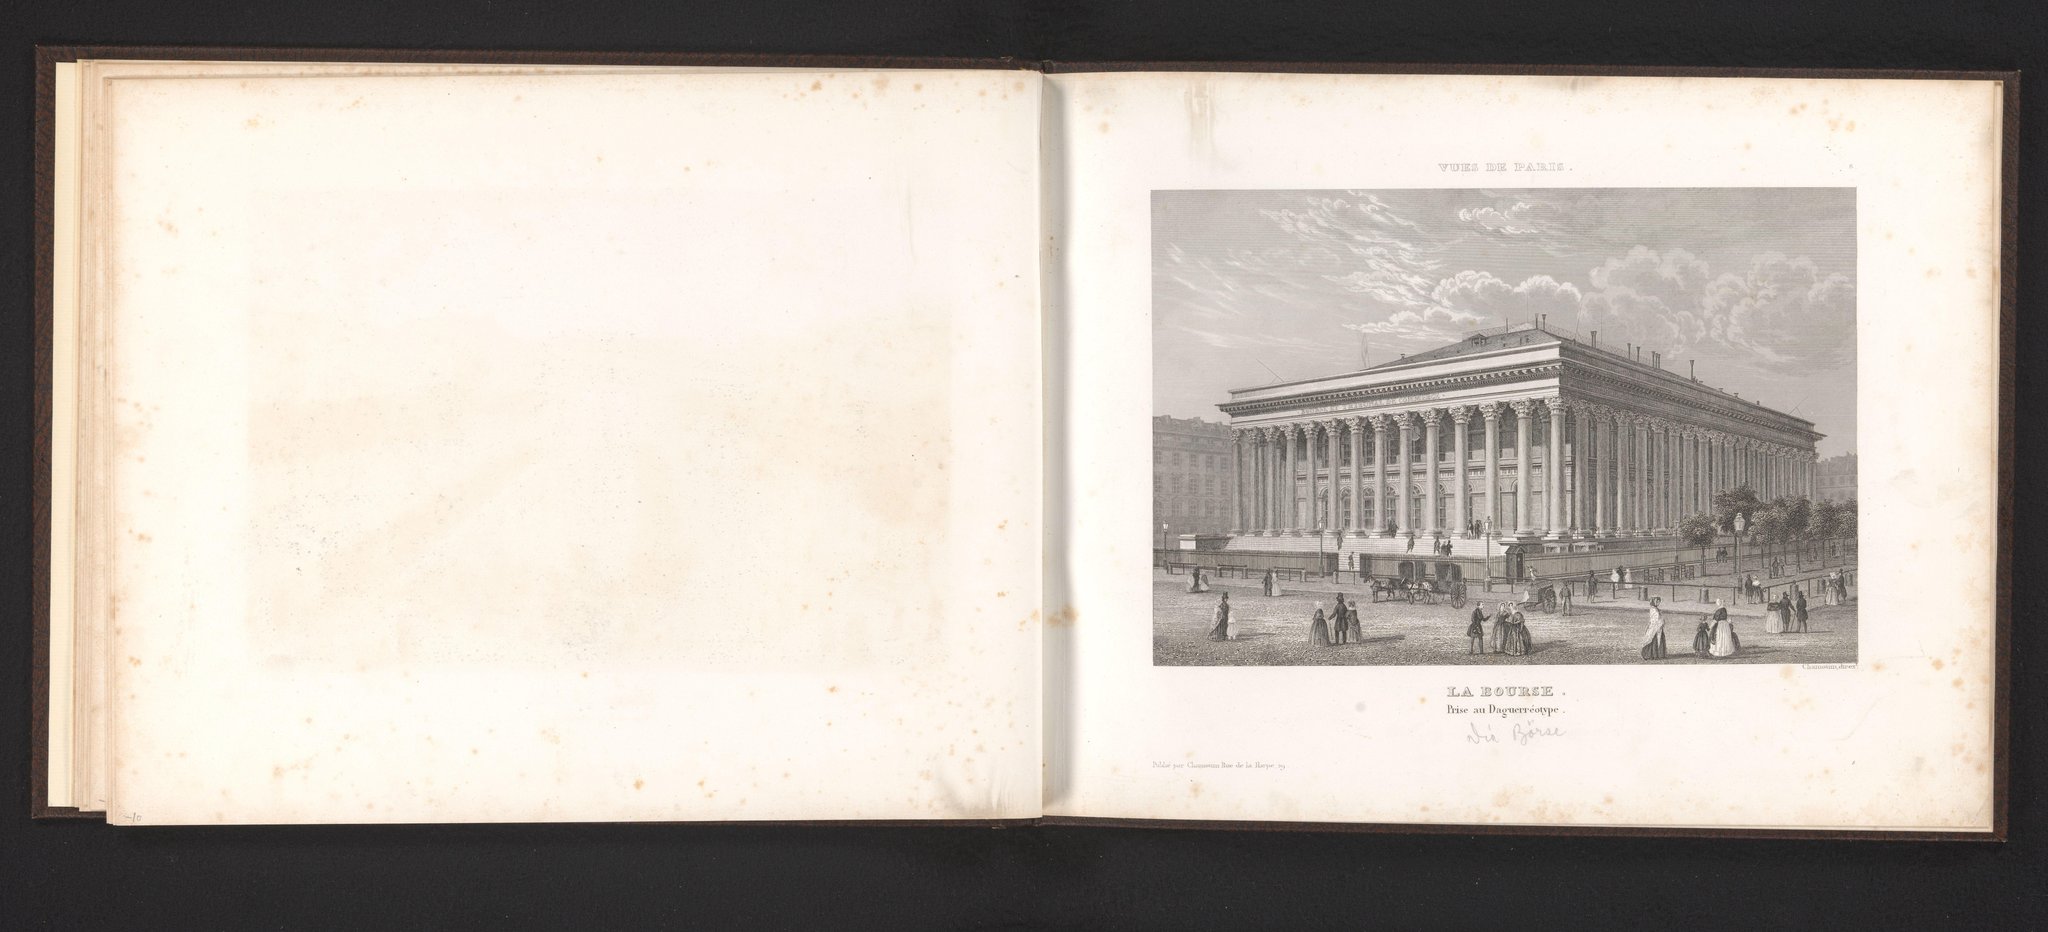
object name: print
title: Gezicht op het Palais Brongniart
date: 1845-1850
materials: paper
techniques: engraving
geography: paris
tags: palace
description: Prent op elfde ongenummerde pagina na titelpagina. Prent gemaakt naar daguerreotypie.